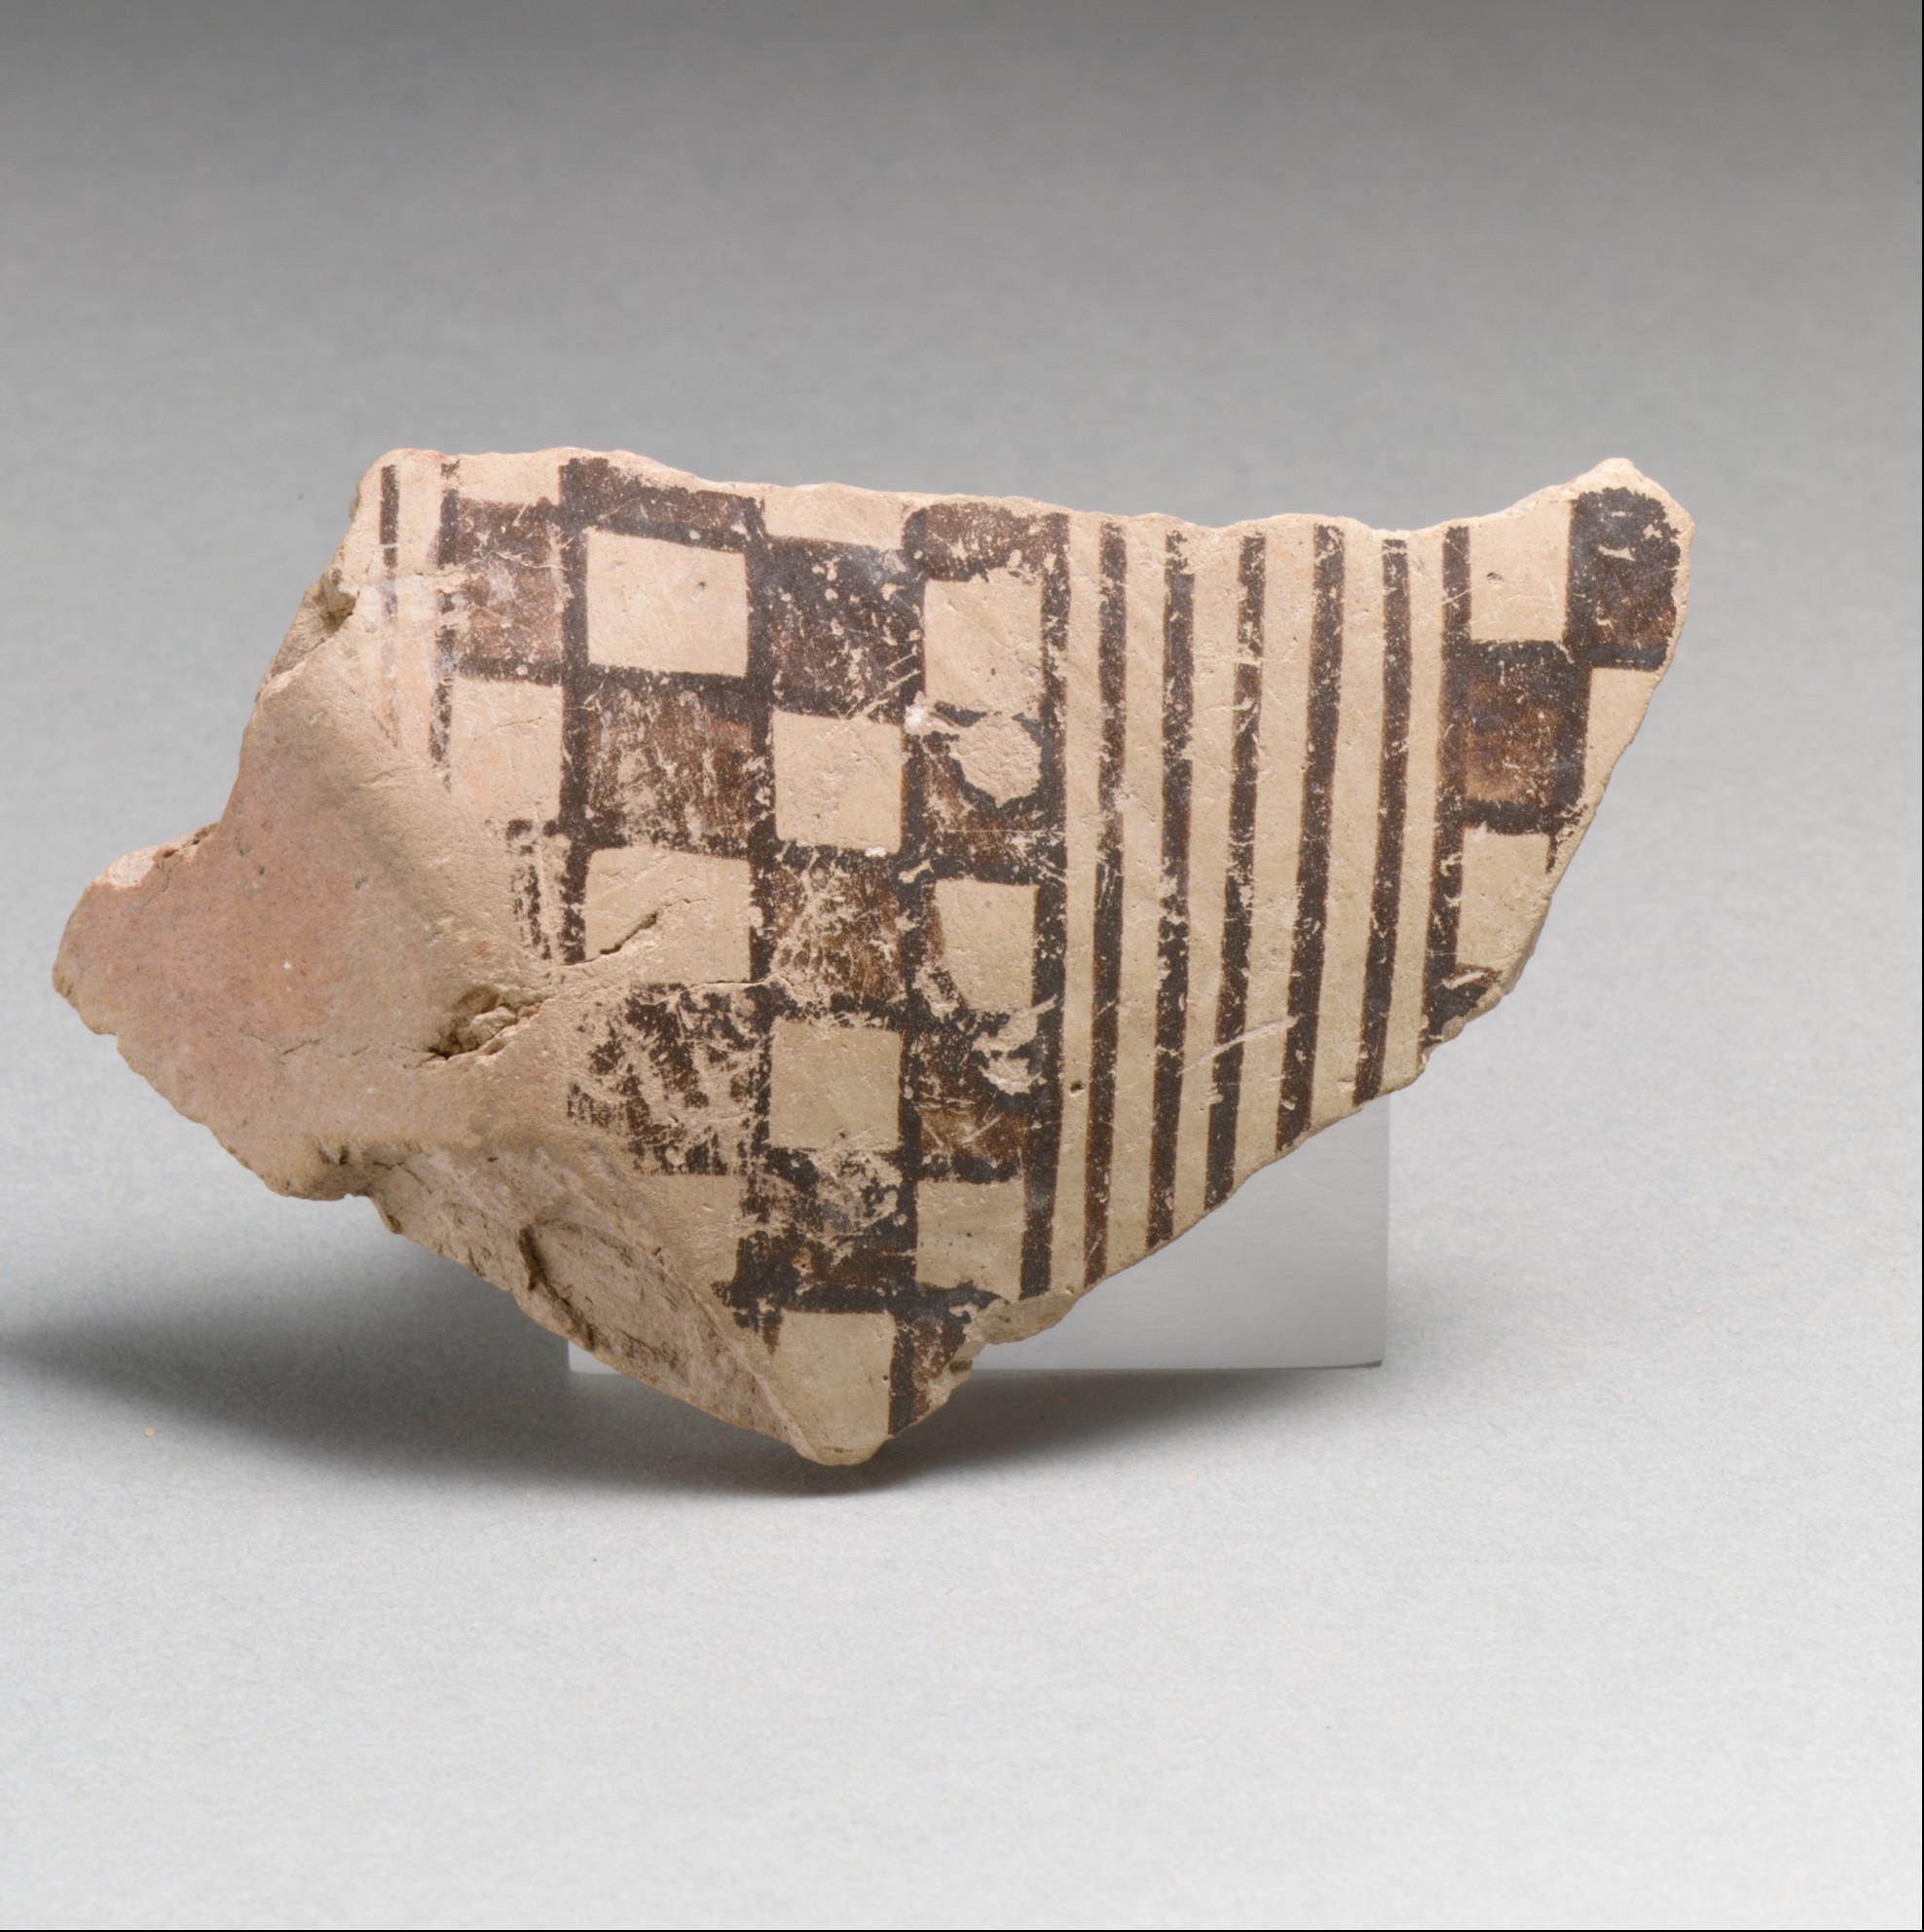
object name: vase fragment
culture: neolithic, thessaly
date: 4000-3000 BCE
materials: terracotta